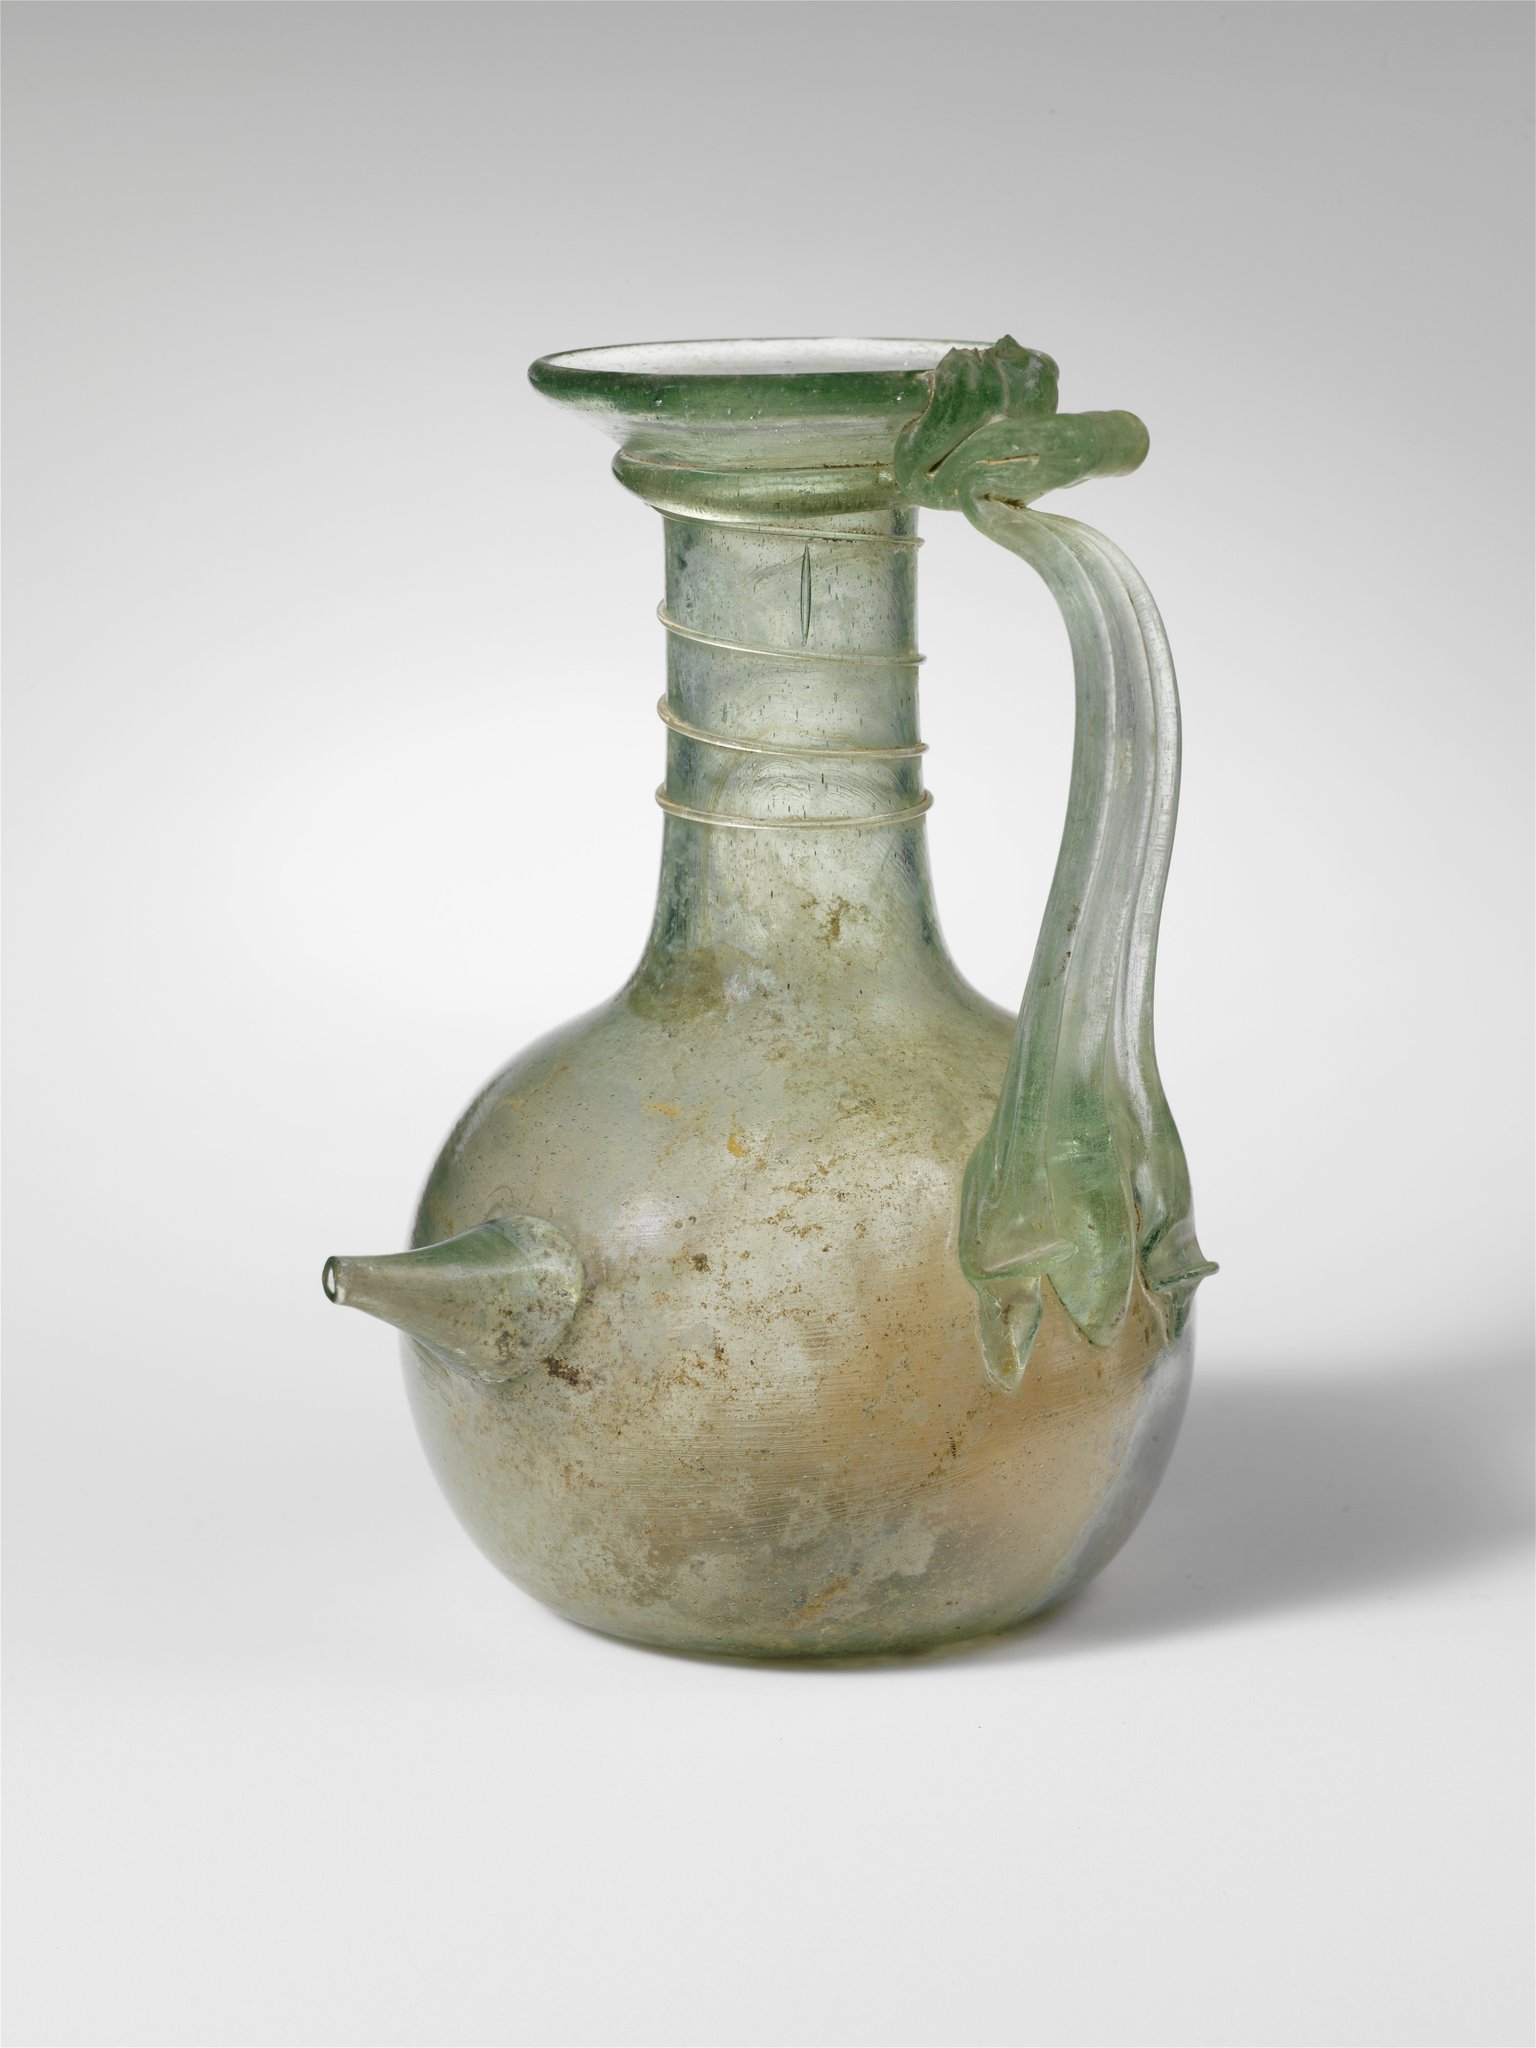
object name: jug, spouted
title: Glass jug with spout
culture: roman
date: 201-400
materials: glass